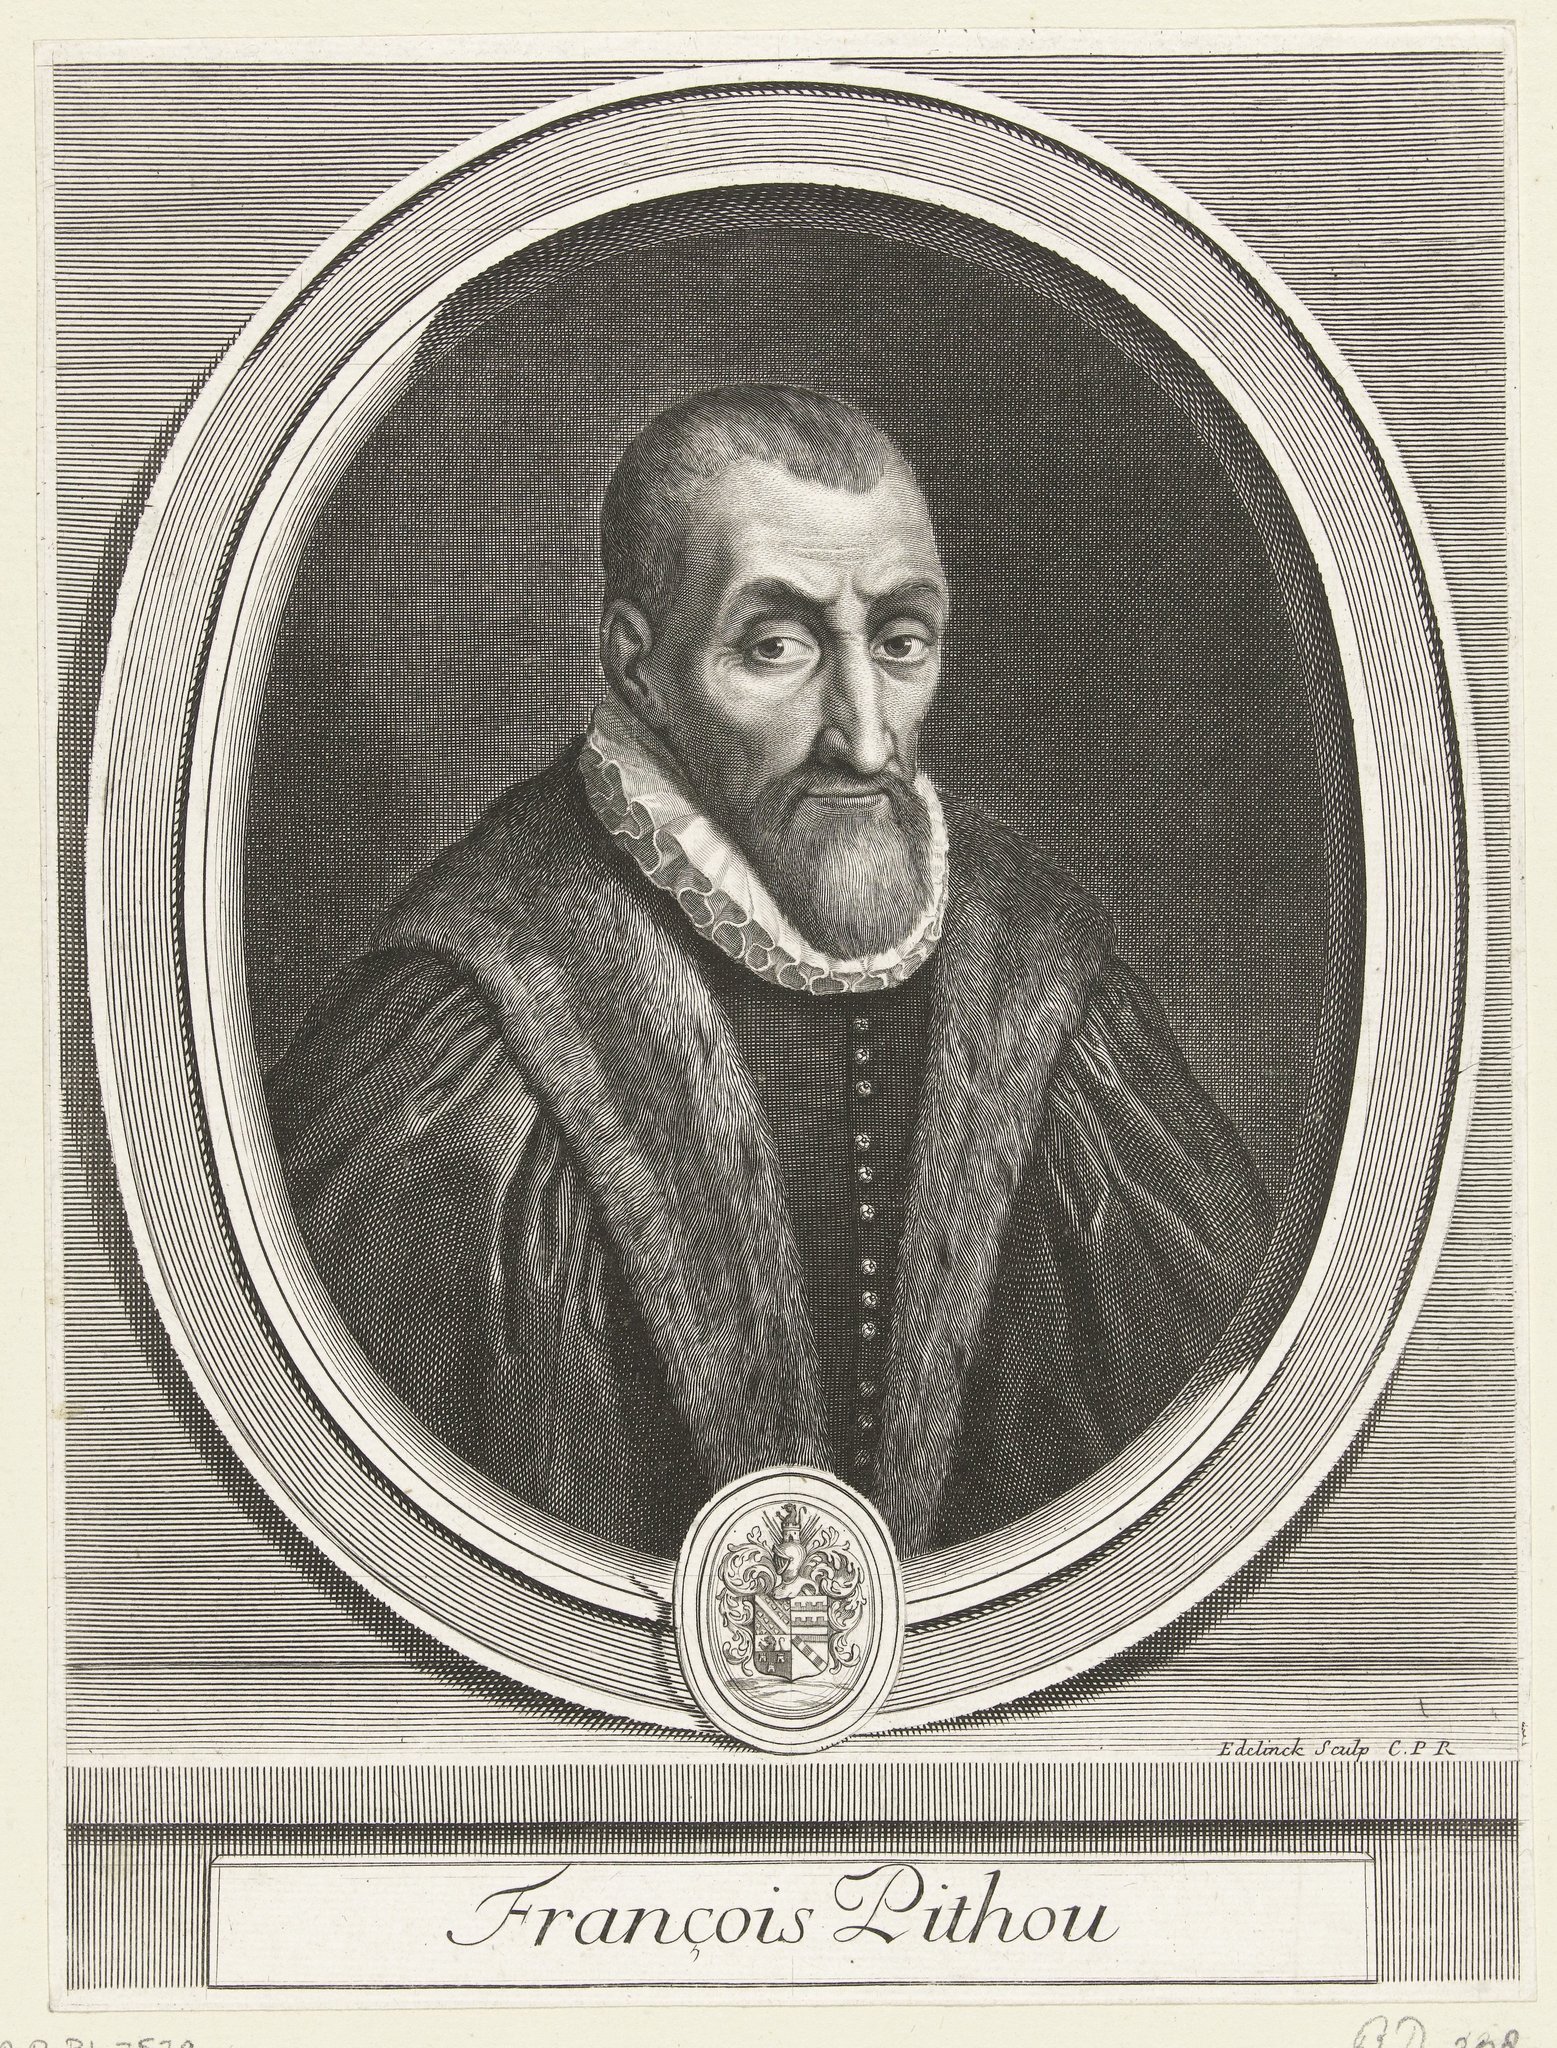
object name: print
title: Portret van François Pithou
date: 1666-1707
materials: paper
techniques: engraving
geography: paris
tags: auteur, françois pithou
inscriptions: collector's mark: Lugt 240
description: Portret van de Franse jurist en auteur François Pithou (1543-1621), afgebeeld in ovale omlijsting met wapen.